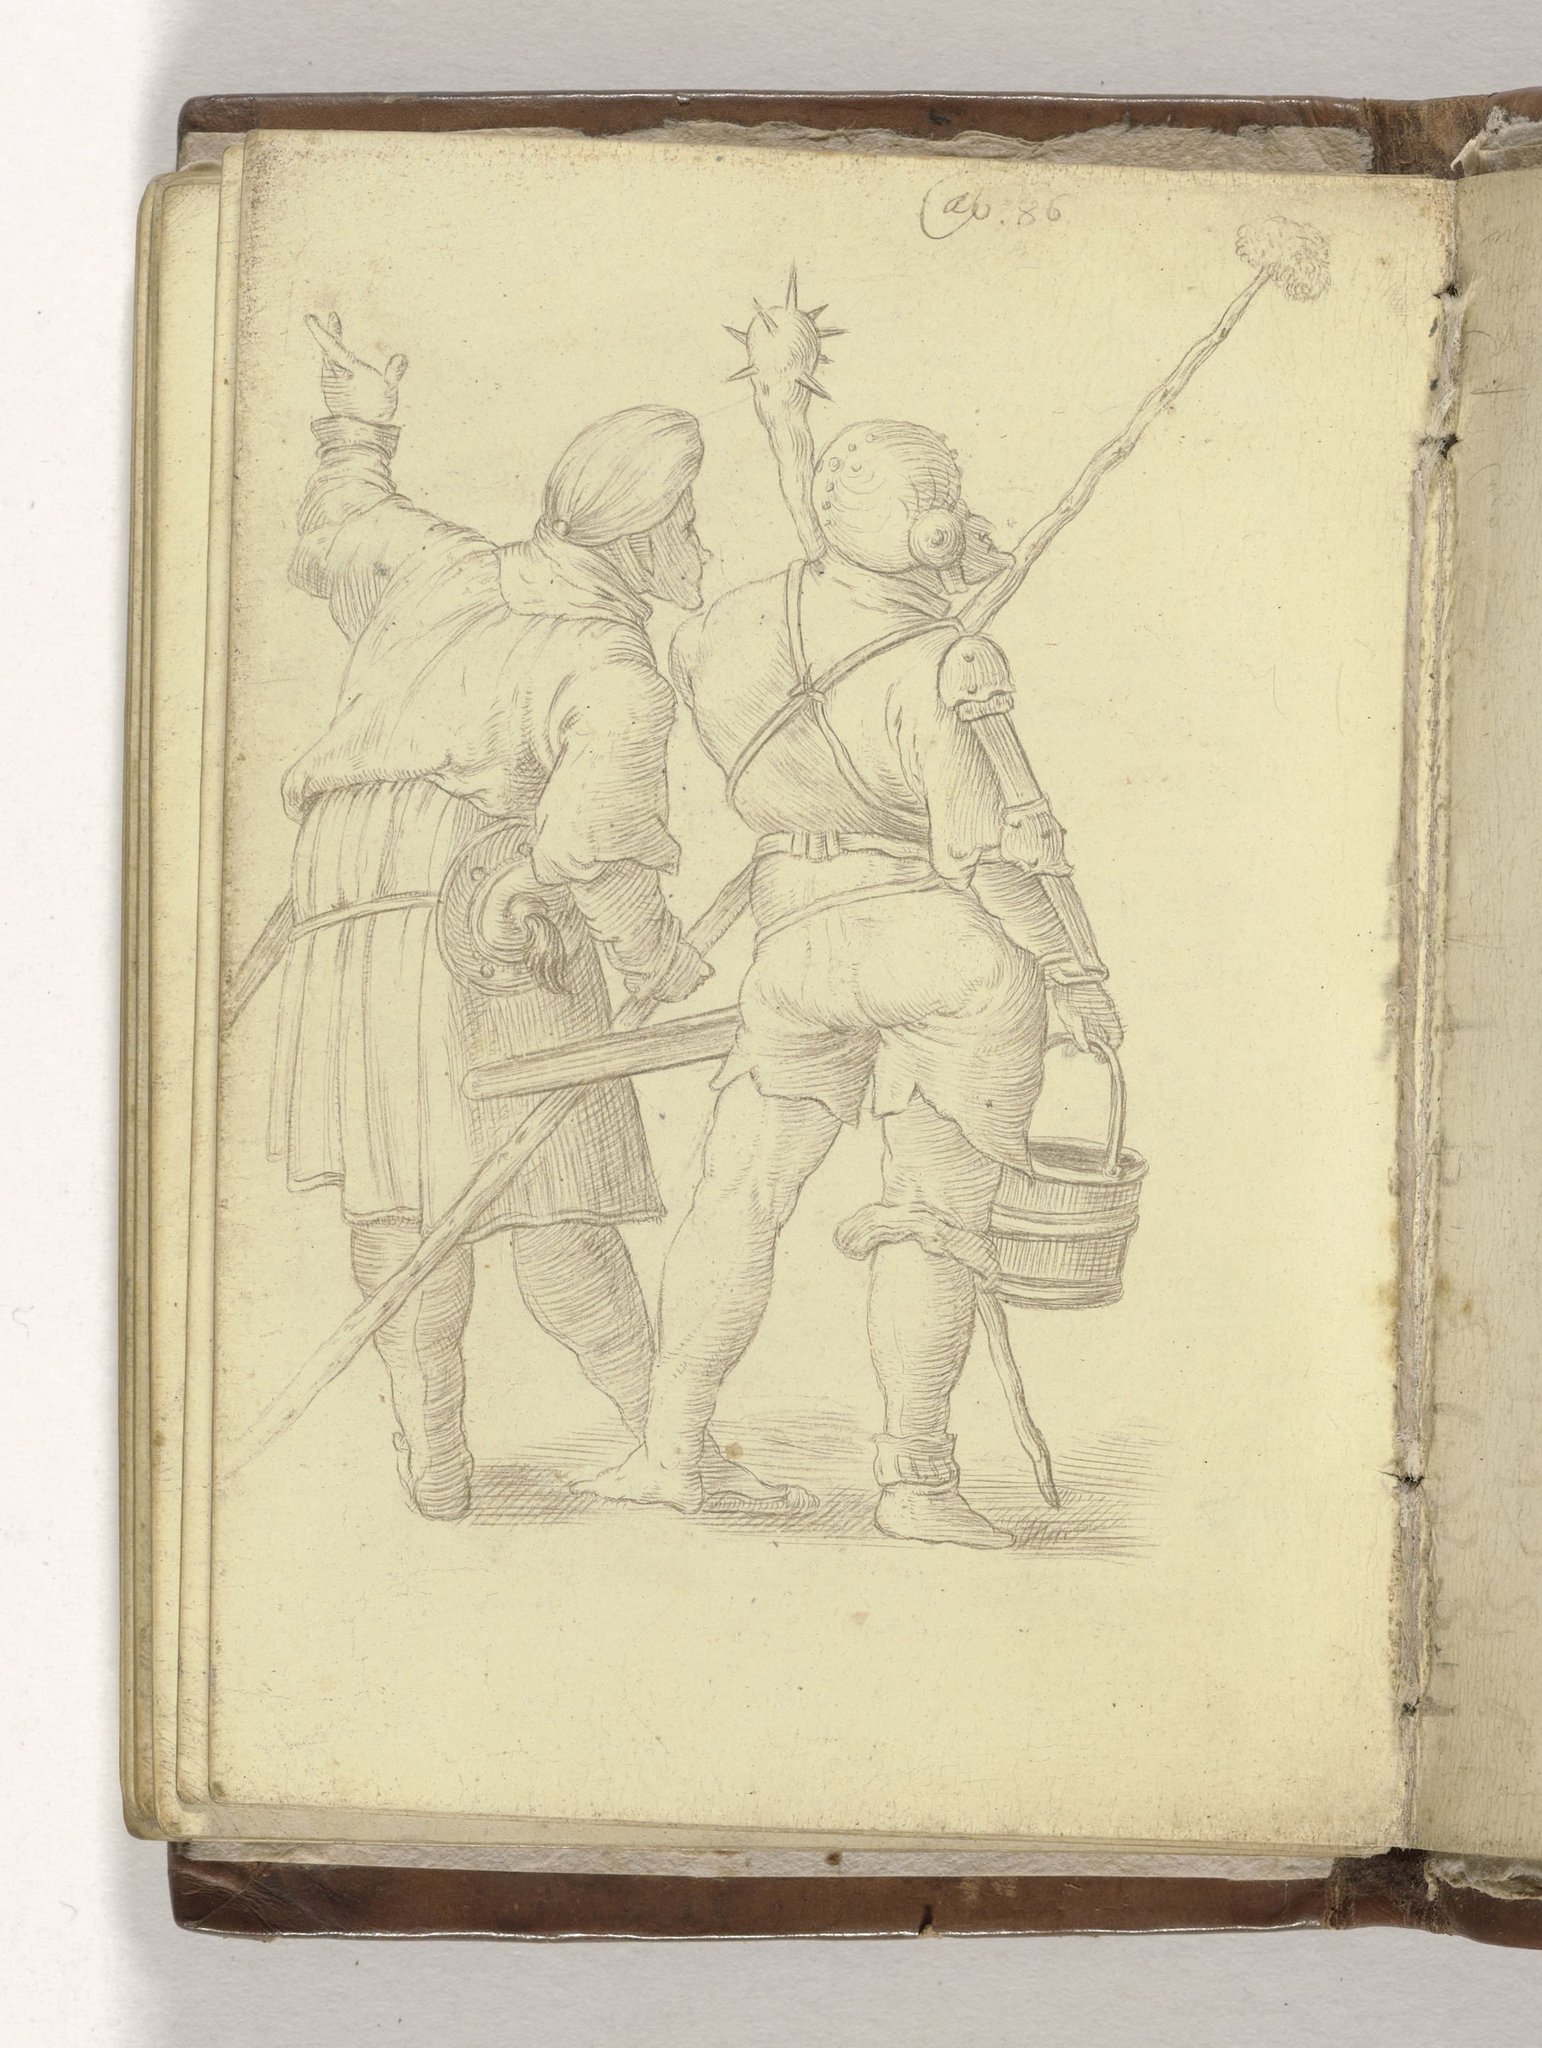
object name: metalpoint drawing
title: Twee staande romeinse soldaten, op de rug gezien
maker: Anonymous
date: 1586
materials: paper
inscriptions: date